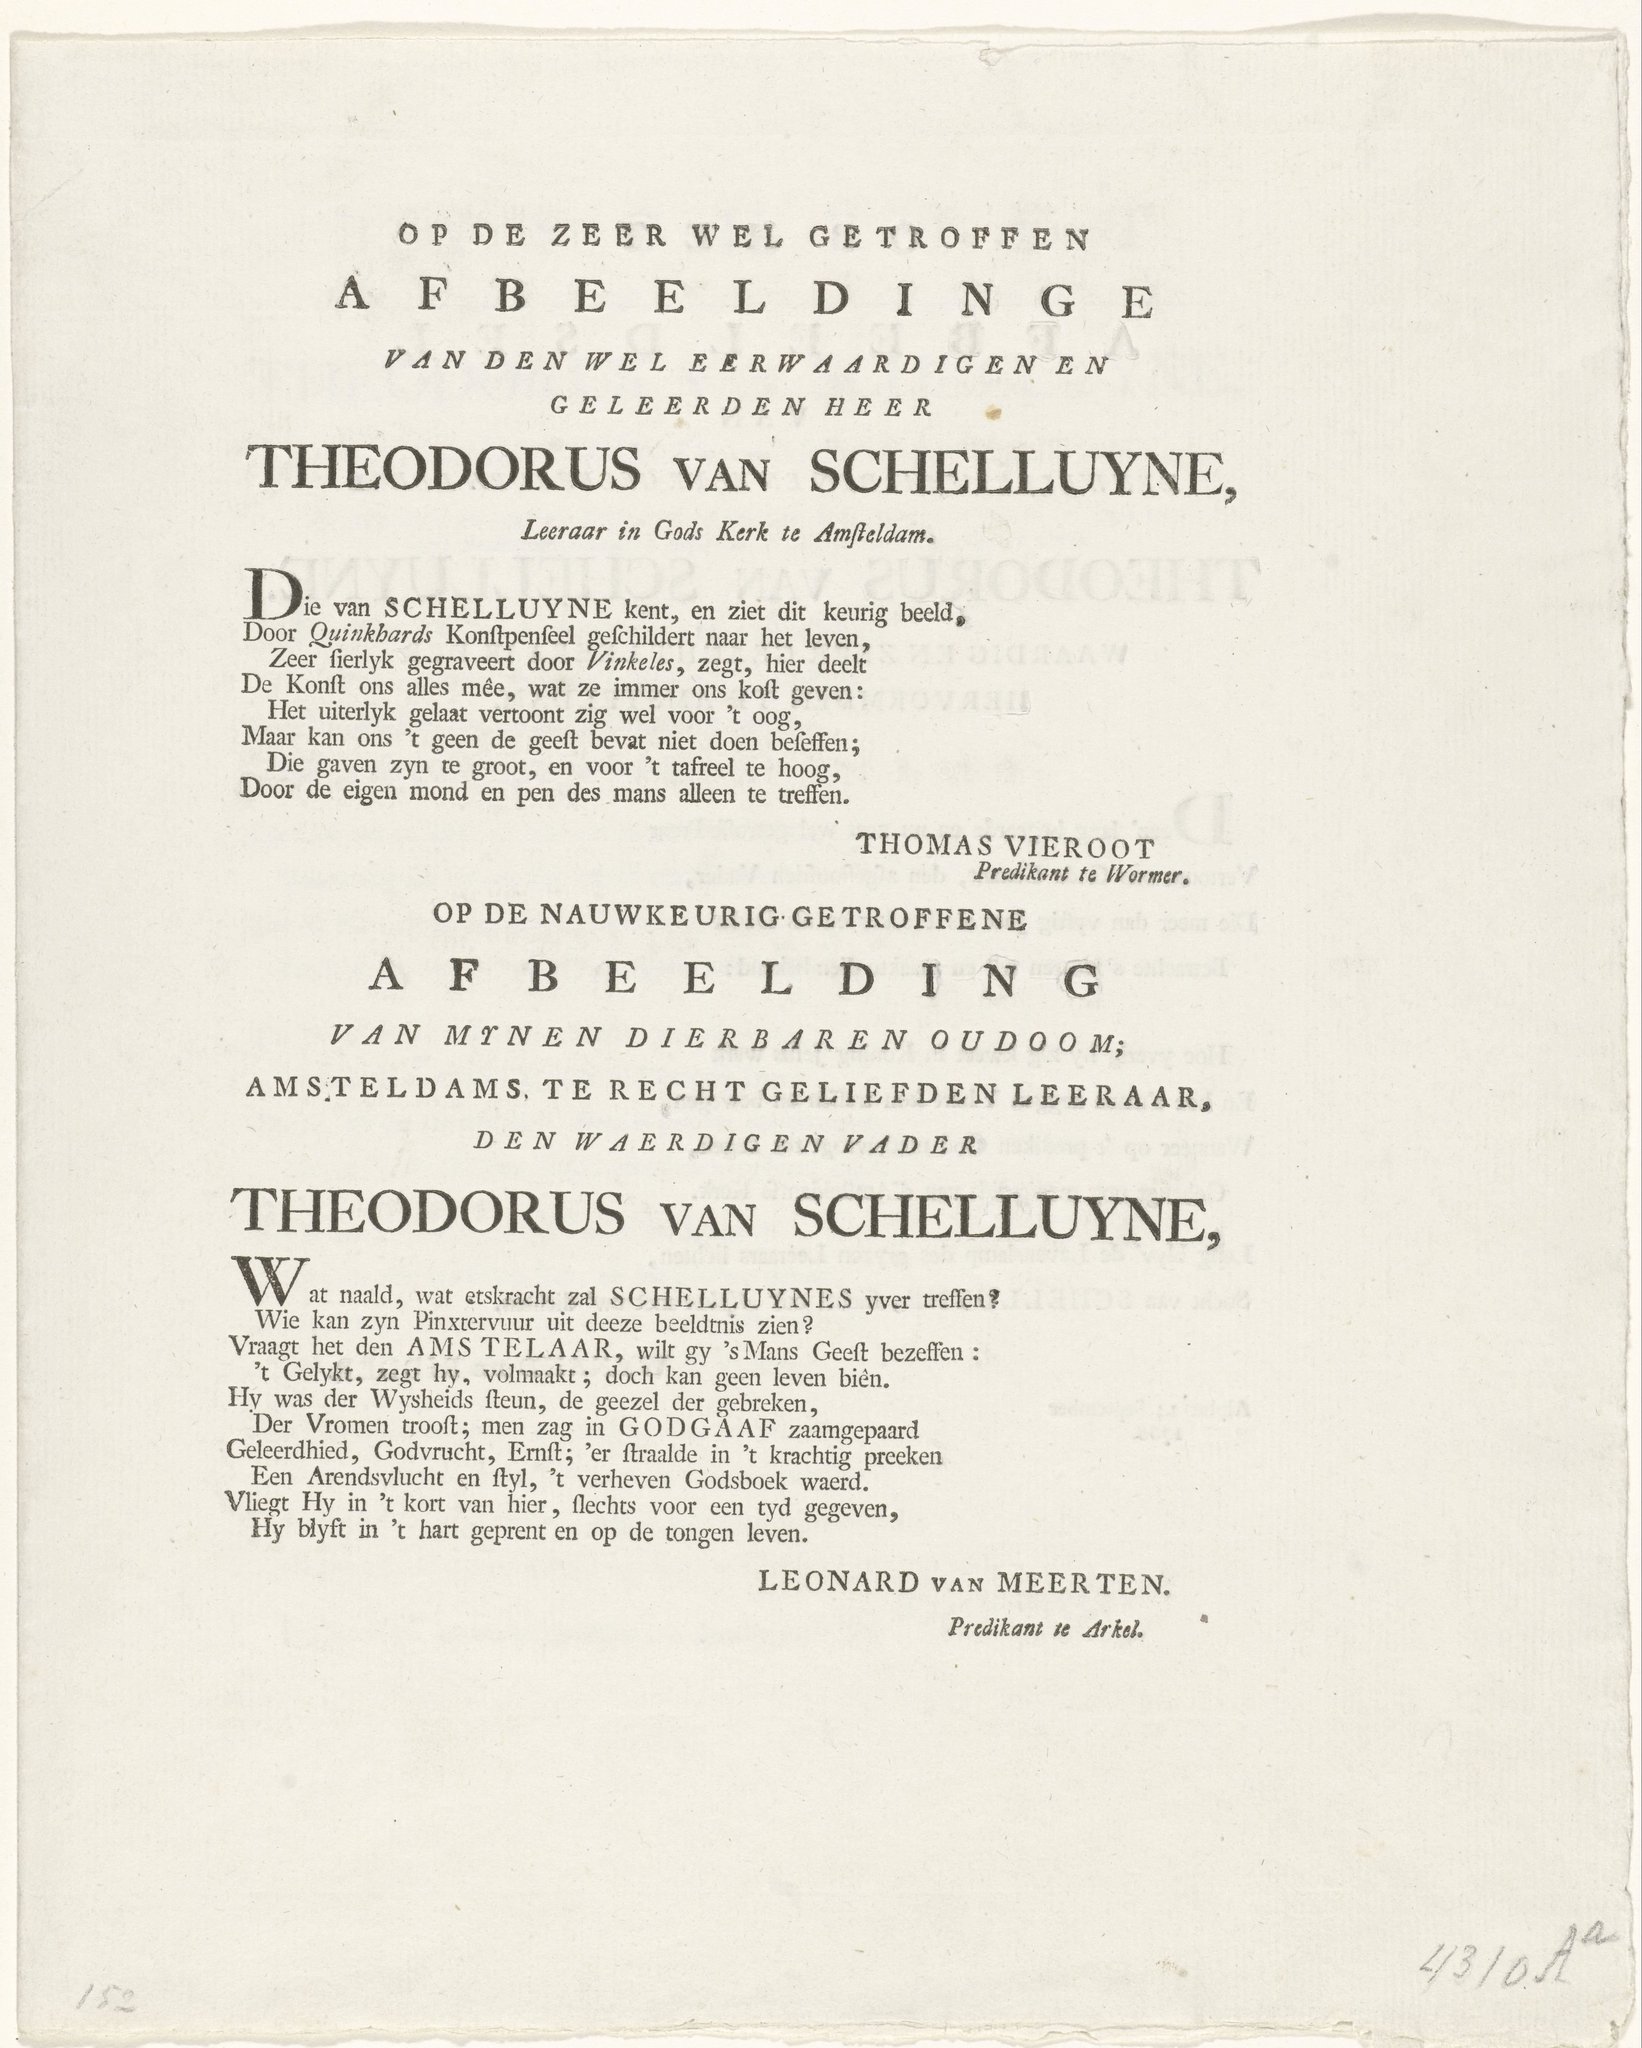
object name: text sheet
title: Verzen op het portret van Theodorus van Schelluynen, 1768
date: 1768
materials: paper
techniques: letterpress printing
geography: wormer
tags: amsterdam, theodorus van schelluynen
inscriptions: collector's mark: Lugt 2228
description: Blad met vier verzen op het portret van Theodorus van Schelluynen, hervormd predikant te Amsterdam, door Rienier Vinkeles naar Jan Maurits Quinkhard uit 1768. Dubbelgevouwen blad bedrukt op vier bladzijden.